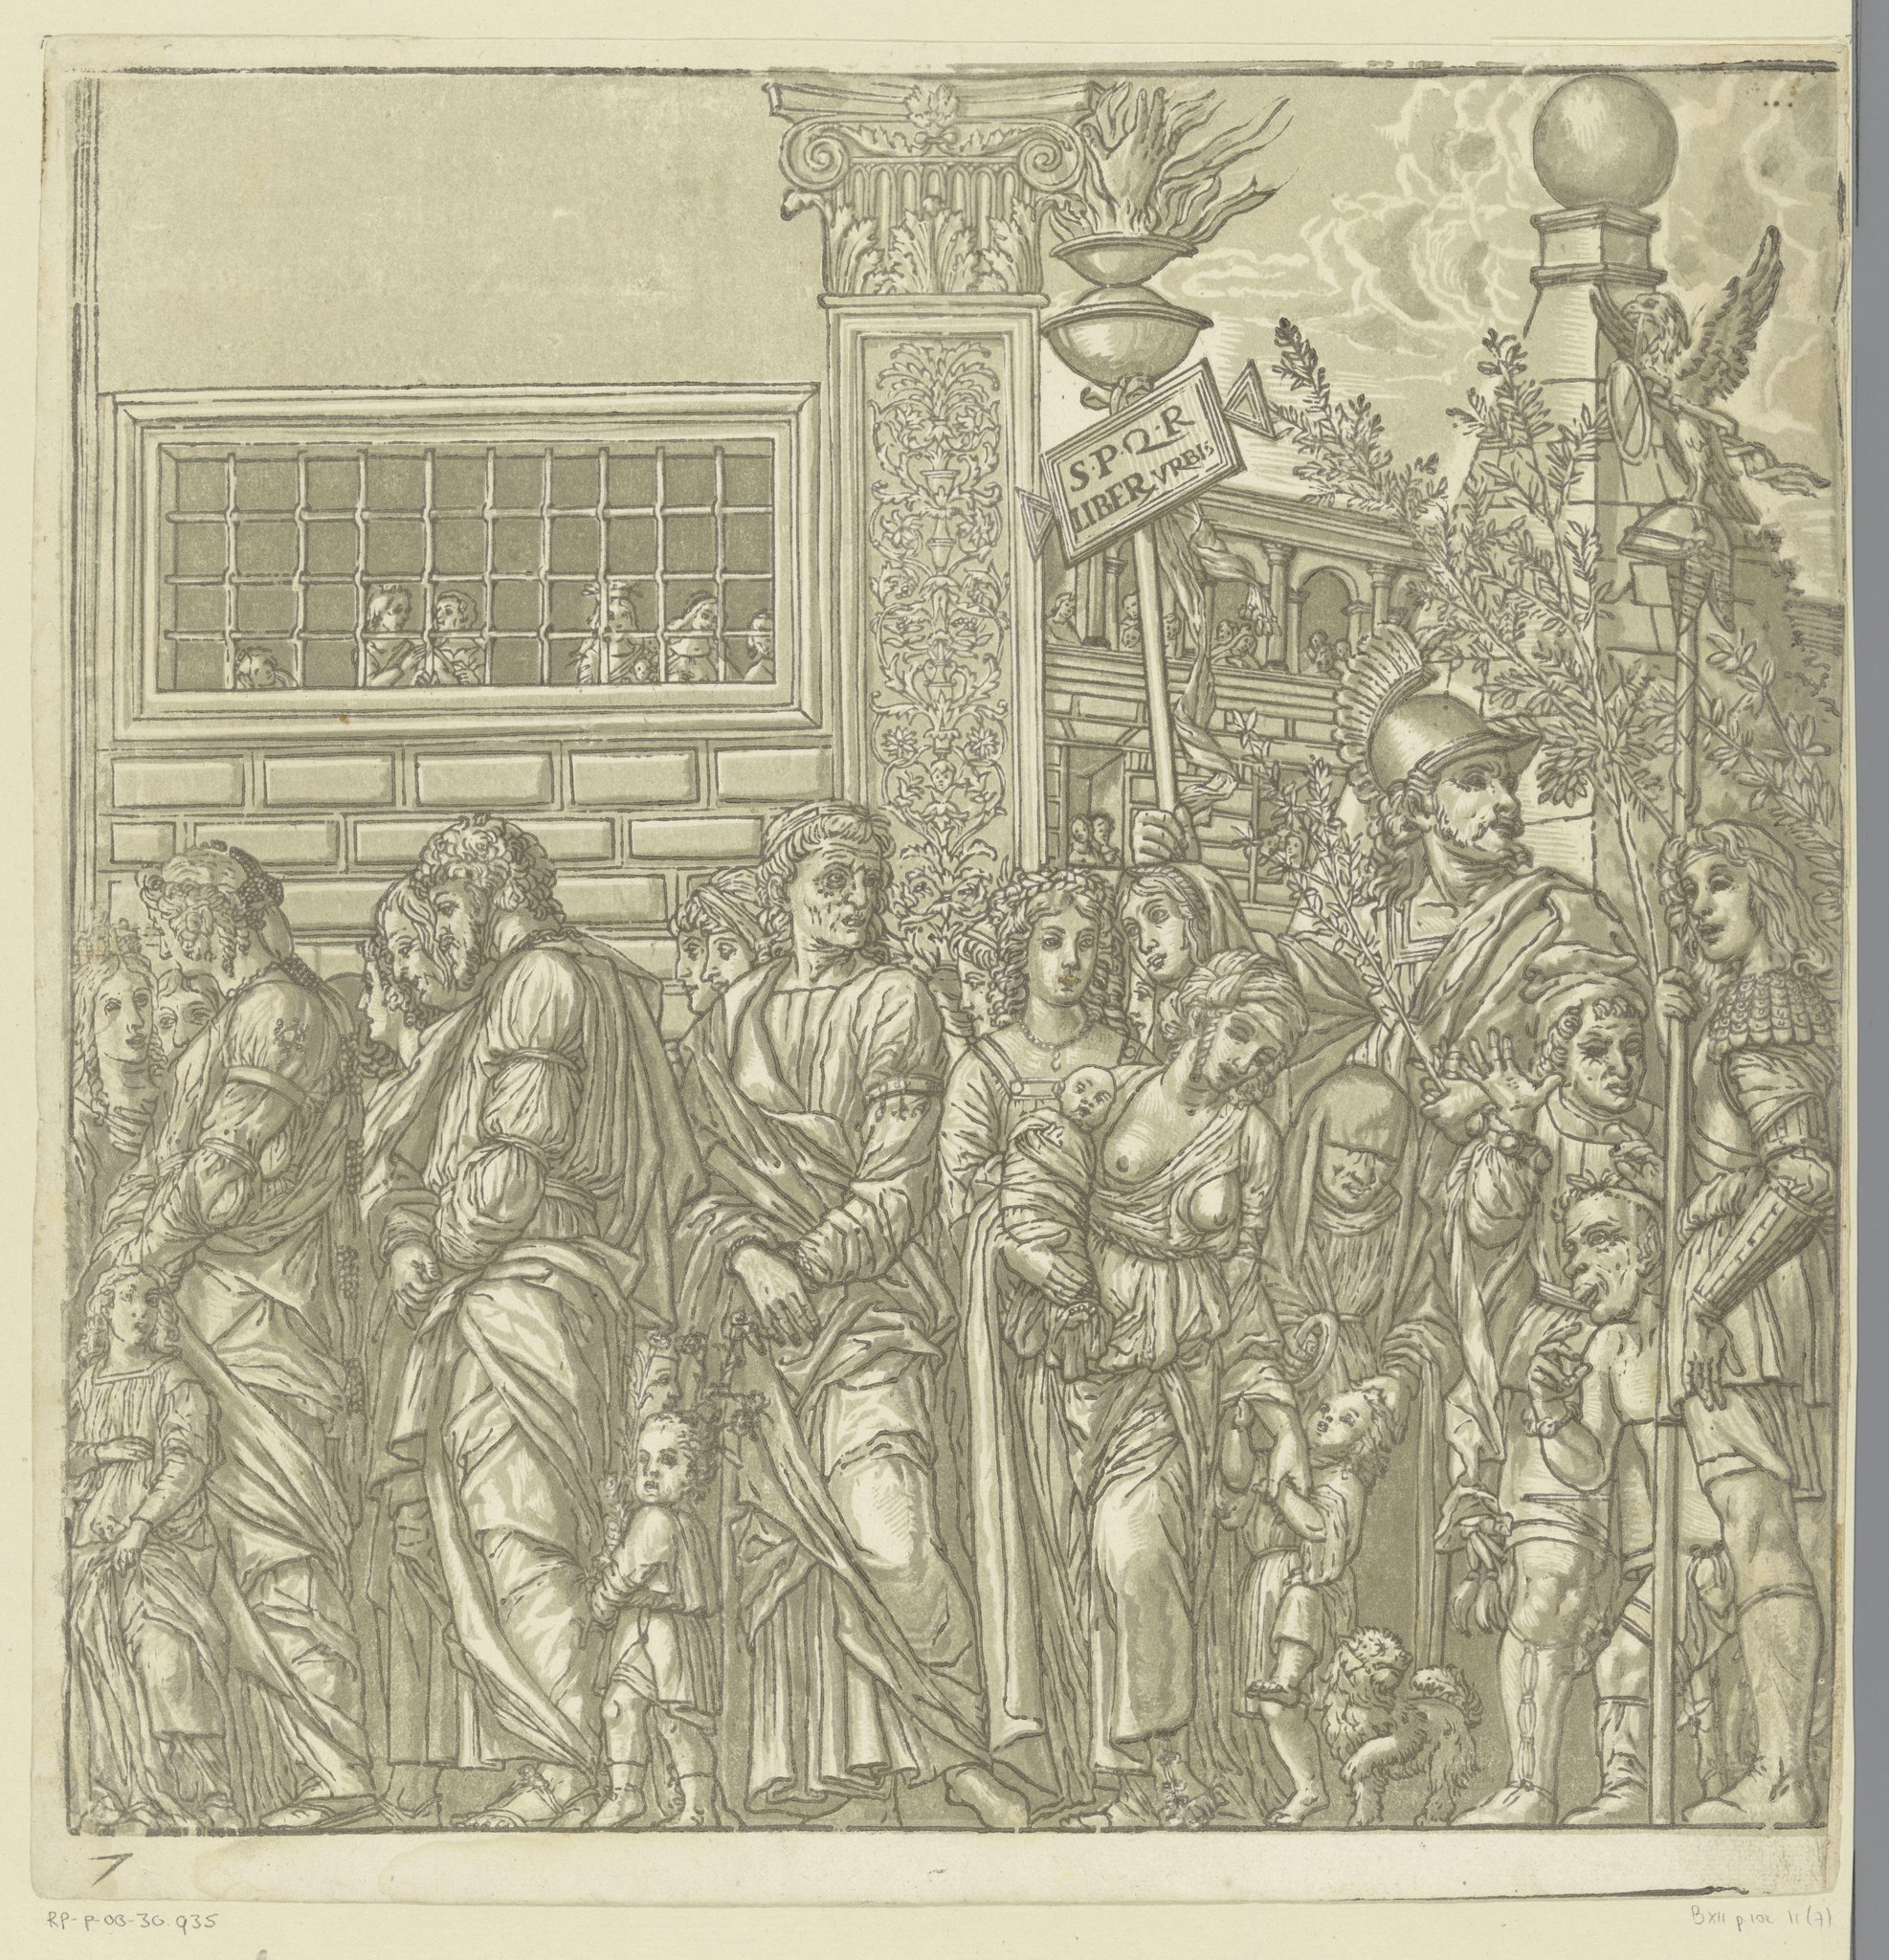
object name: print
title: Triomftocht van Julius Caesar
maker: andrea andreani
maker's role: print maker, printer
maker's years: 1558-1629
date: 1599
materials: paper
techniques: woodcut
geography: italy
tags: torch, triumph of caesar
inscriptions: collector's mark: Lugt 240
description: Deze prent maakt deel uit van een fries dat bestaat uit een titelprent en negen prenten die samen een triomftocht van Julius Caesar vormen. Bij de serie hoort tevens een prent met daarop zes Korinthische pilasters, bedoeld om te worden uitgeknipt en gebruikt als verbindingsstukken tussen de verschillende bladen.